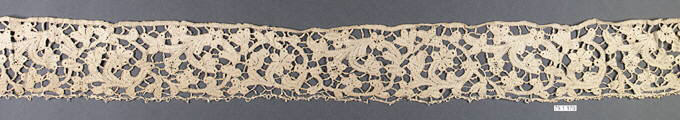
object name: strip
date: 1601-1700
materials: lace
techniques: lace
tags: birds,flowers